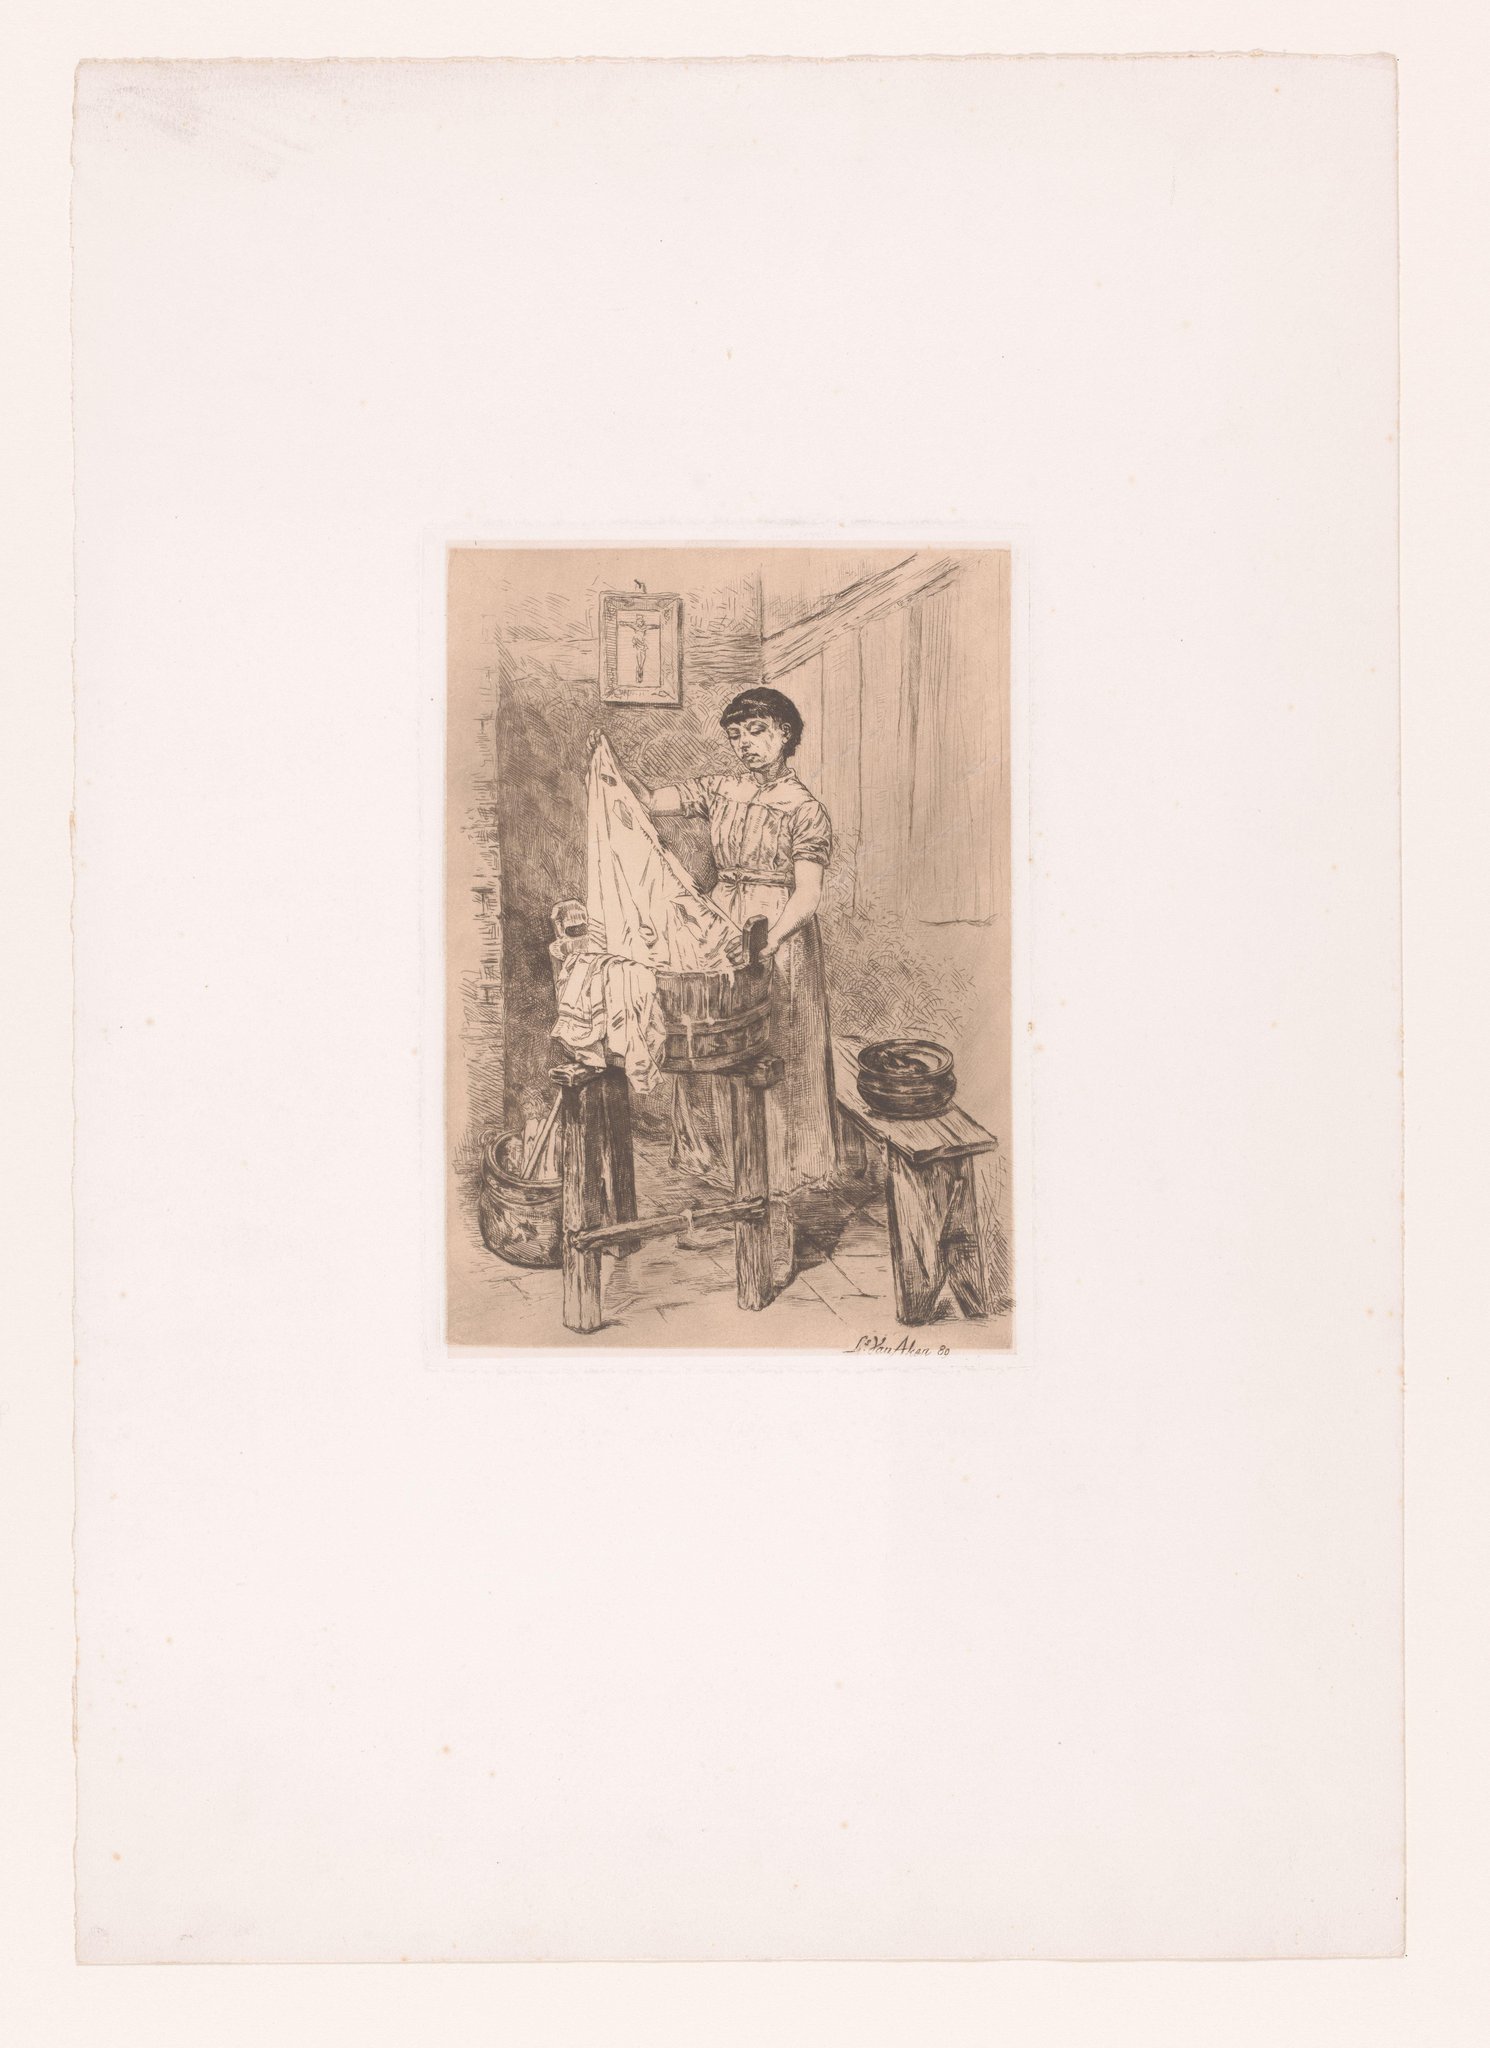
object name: print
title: Wassende jonge vrouw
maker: leo van aken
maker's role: print maker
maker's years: 1857-1904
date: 1889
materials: paper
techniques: etching, intaglio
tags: adolescent, young woman, maiden, laundering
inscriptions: collector's mark: Lugt 2228